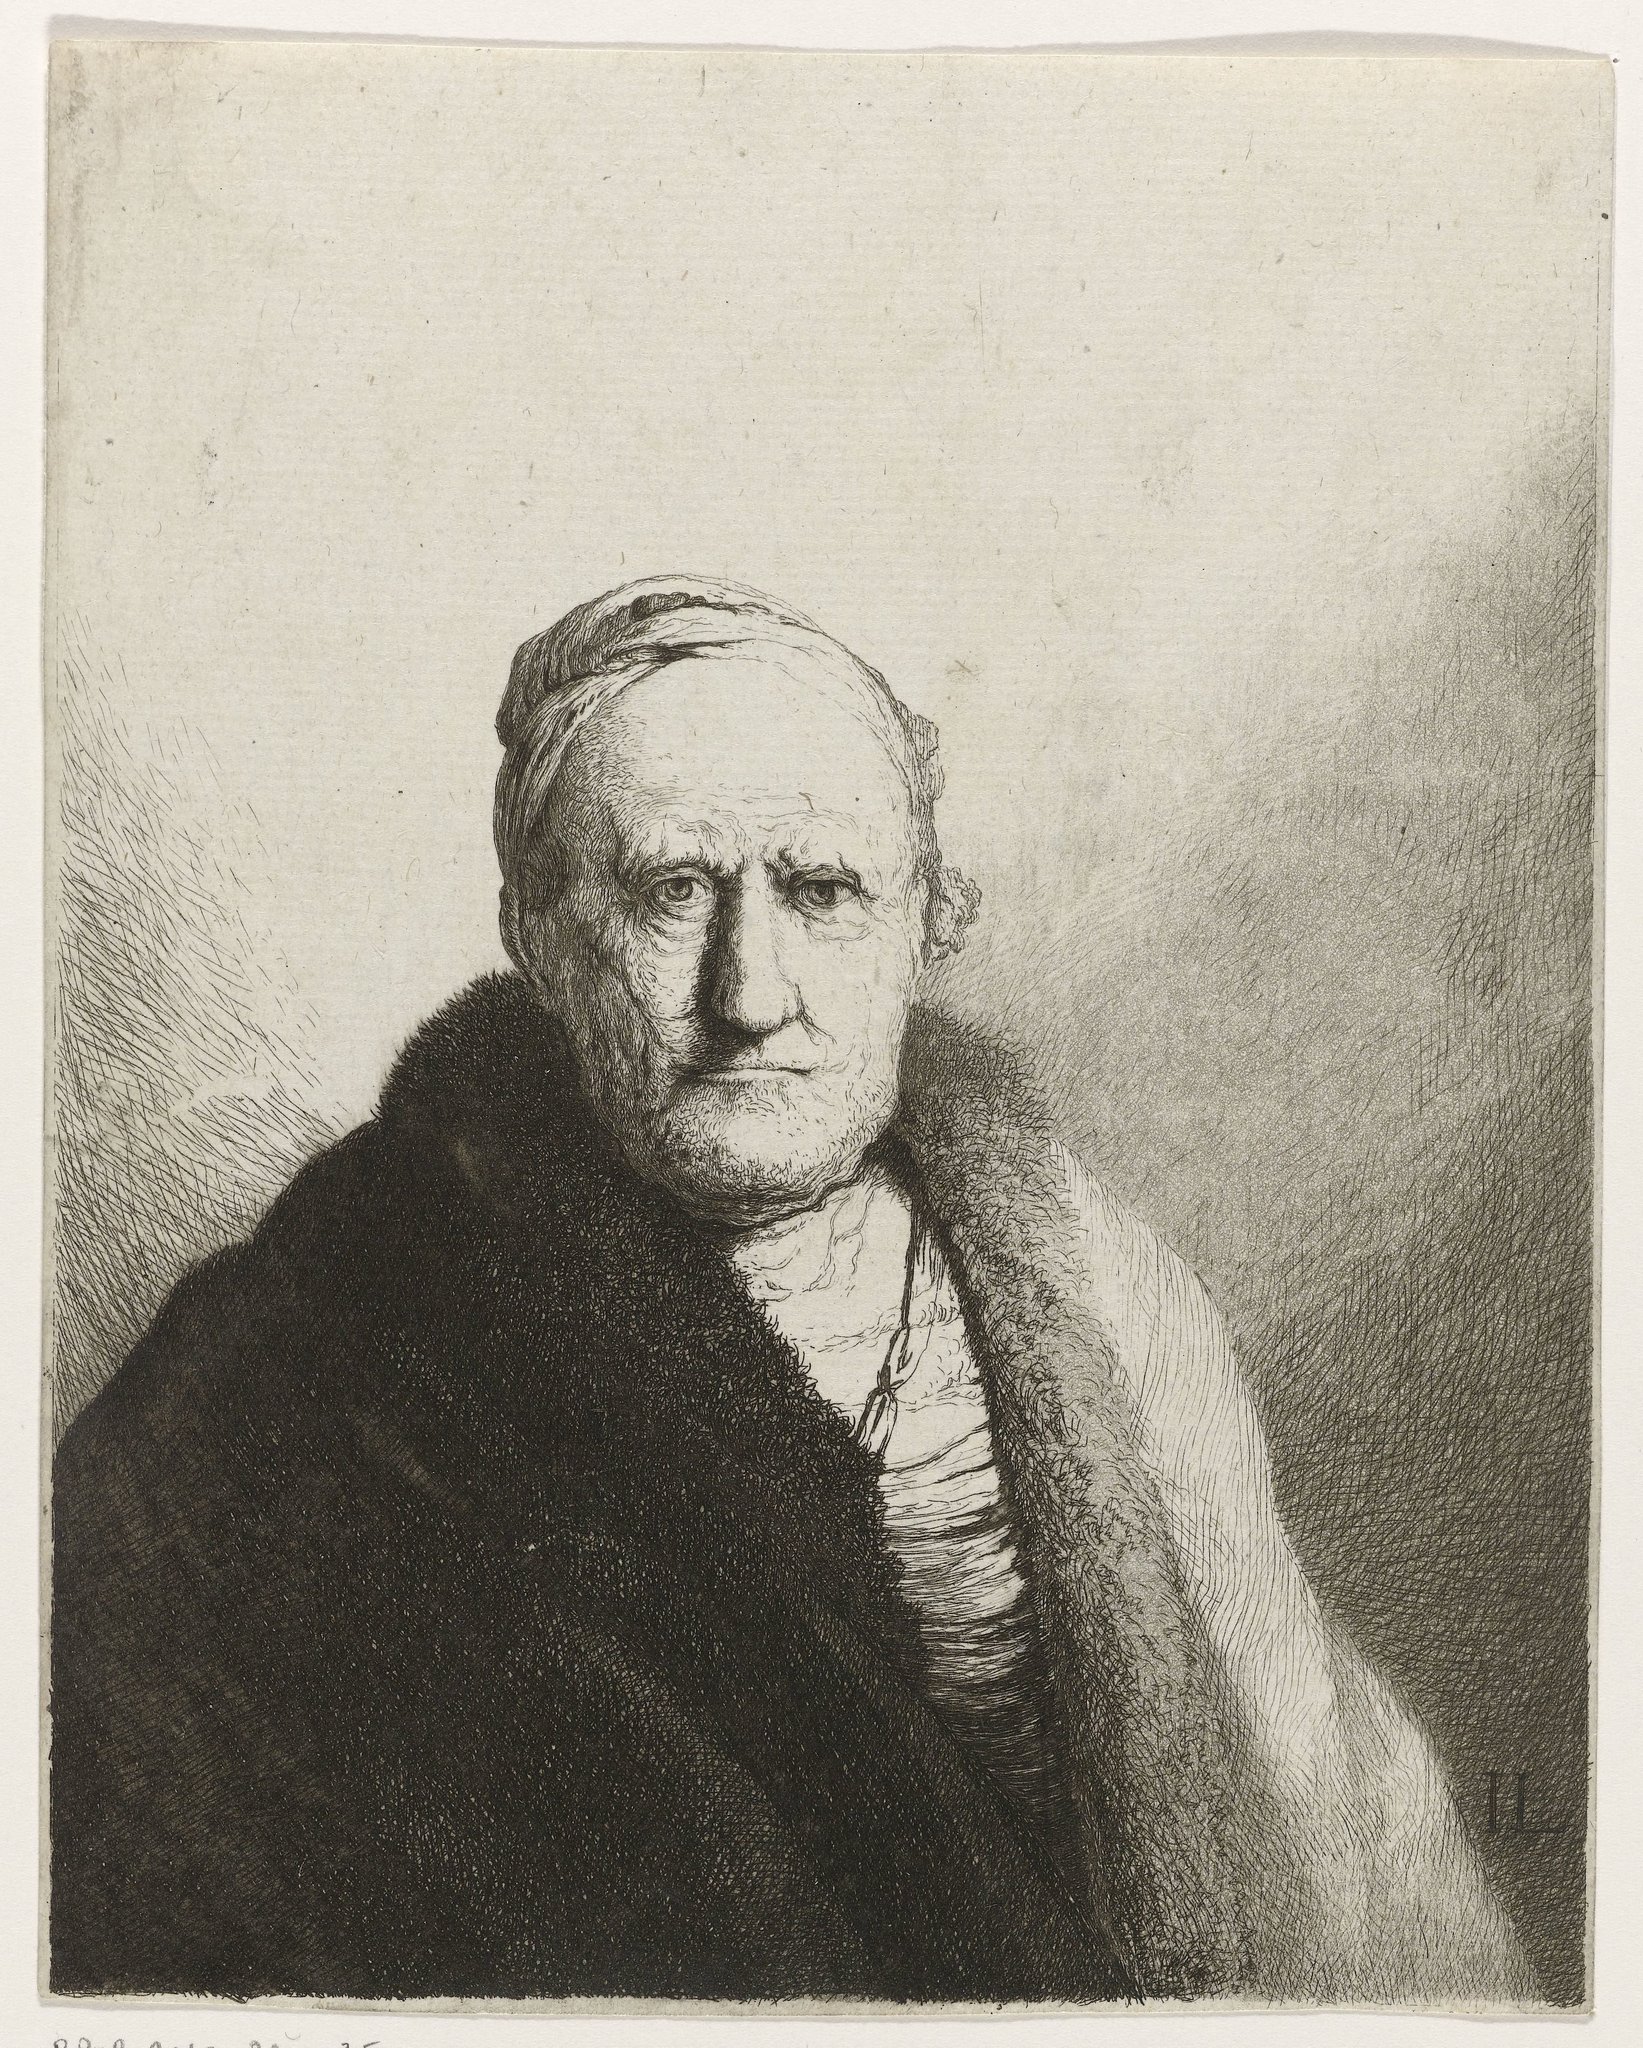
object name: print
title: Portrait of a Man in a Fur Coat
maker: Anonymous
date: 1700-1800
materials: paper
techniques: aquatint, etching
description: Most portrait prints bear the names of the makers and the sitters. Prints that lack them are sometimes puzzling. This rare etching of an elderly man in a fur coat, for example, was long attributed to the 17th-century artist Jan Lievens, a friend of Rembrandt. The print, however, dates from the 18th century, and its creator remains unknown for now.